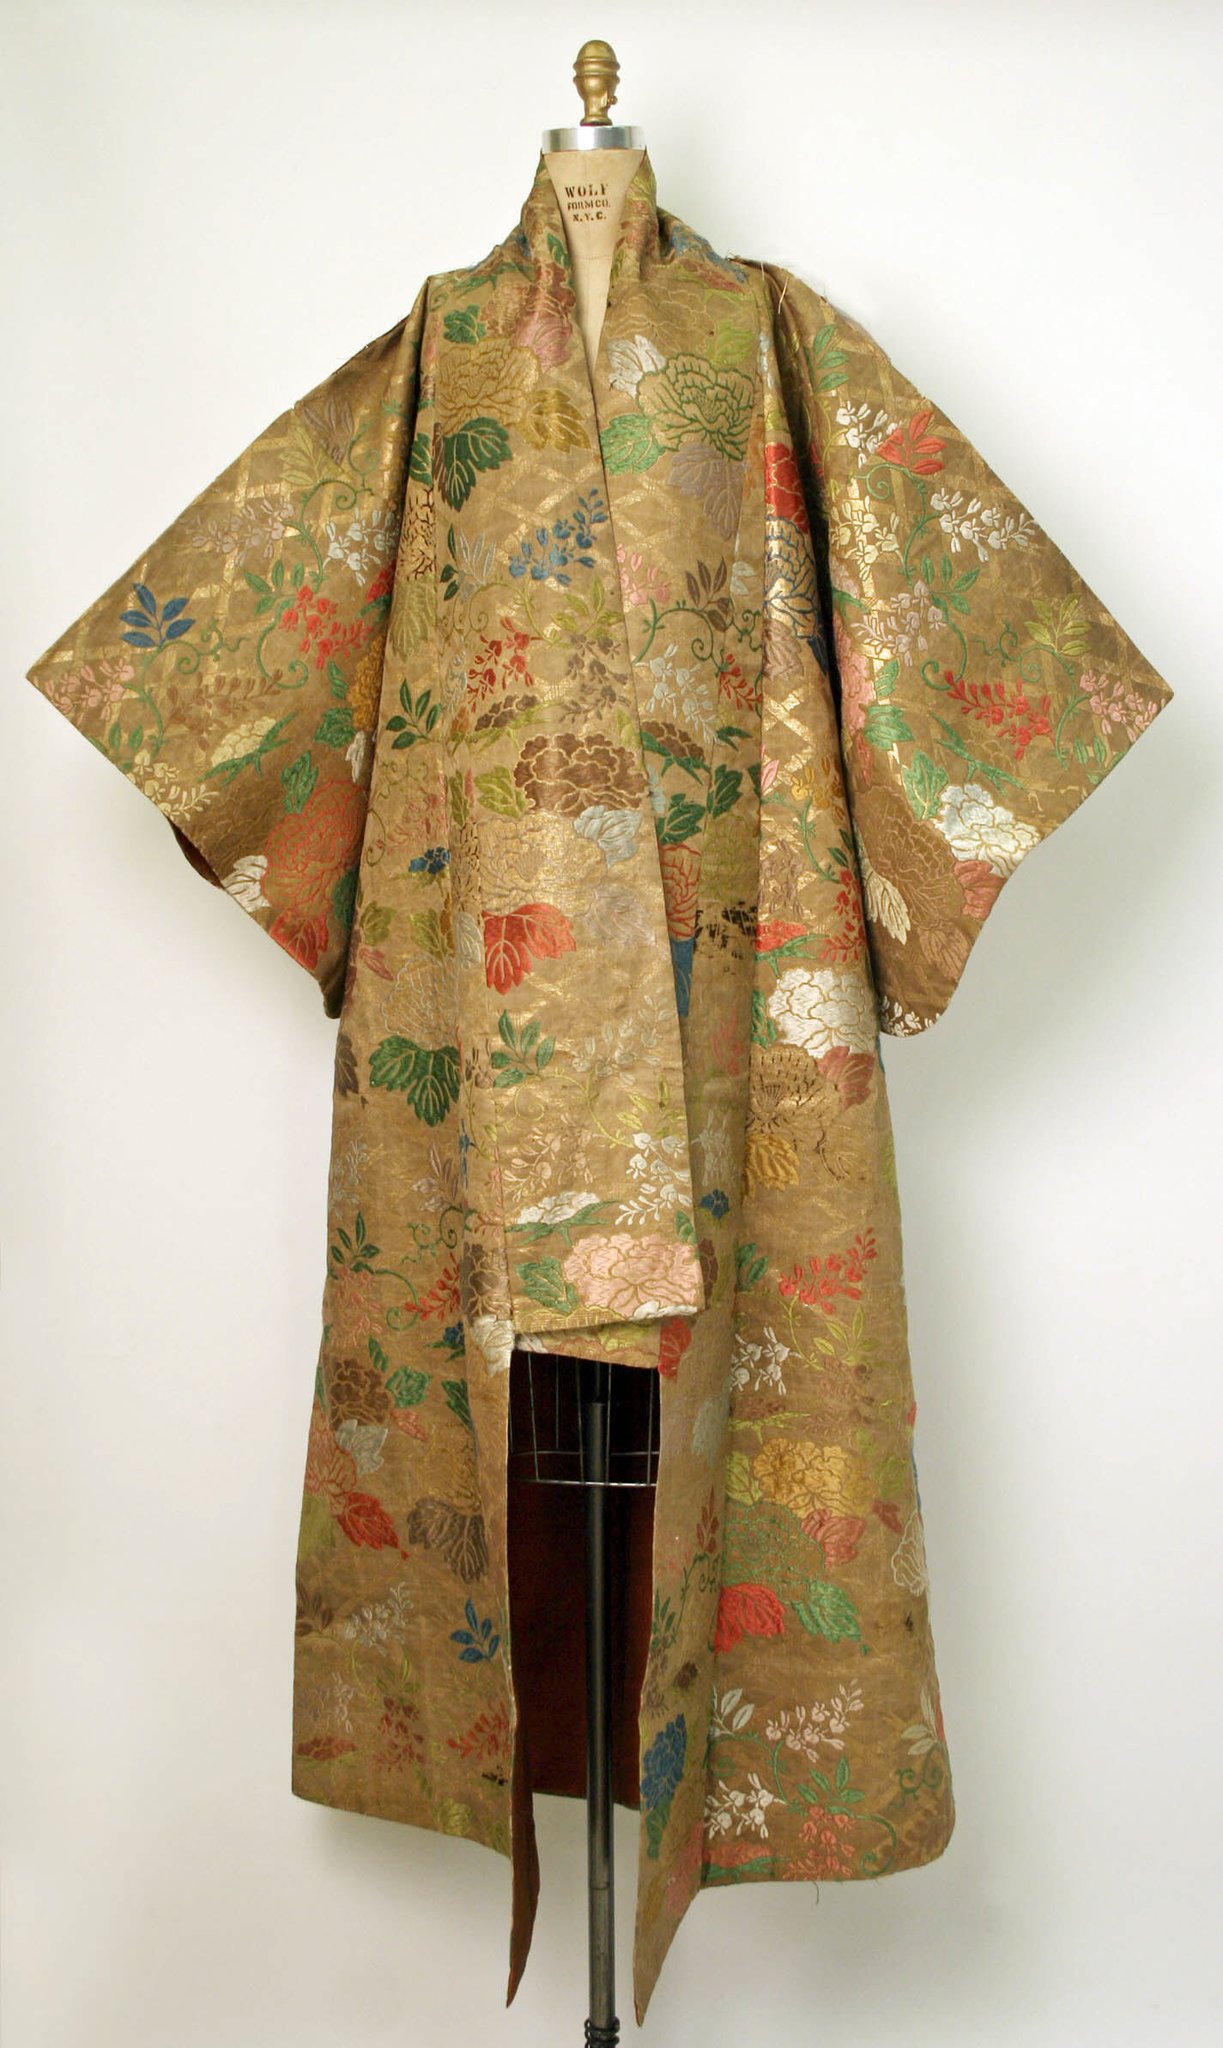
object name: theatrical costume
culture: japanese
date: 1701-1800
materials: silk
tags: flowers